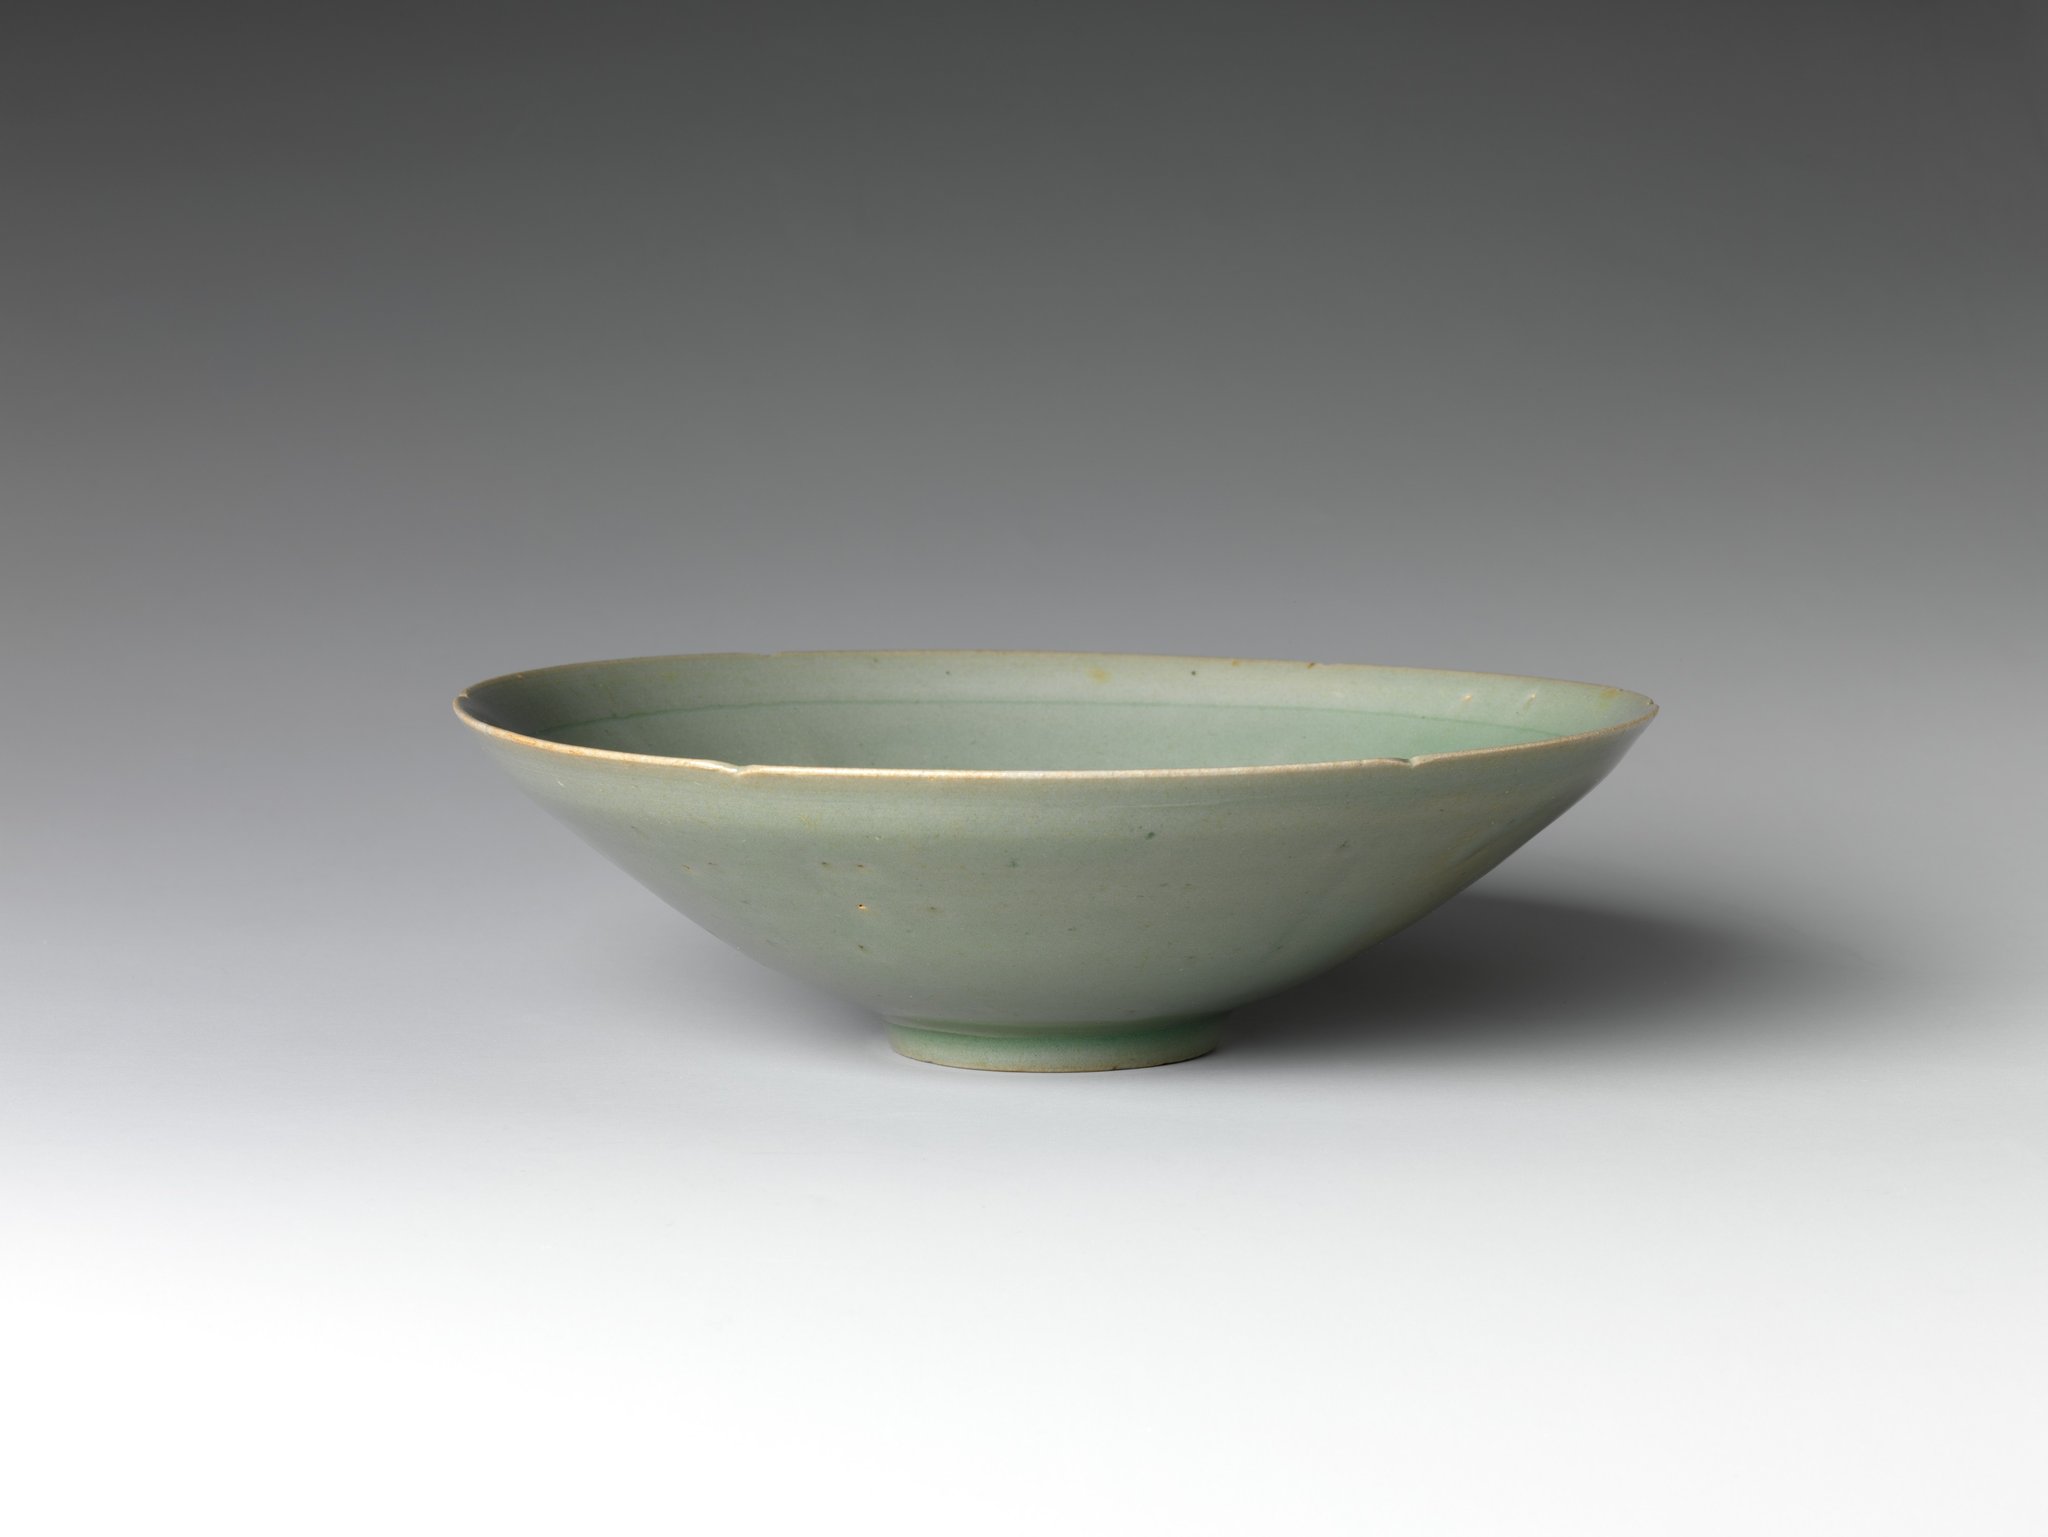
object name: bowl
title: Six-lobed bowl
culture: korean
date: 1101-1133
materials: ceramic glaze, glaze, stoneware